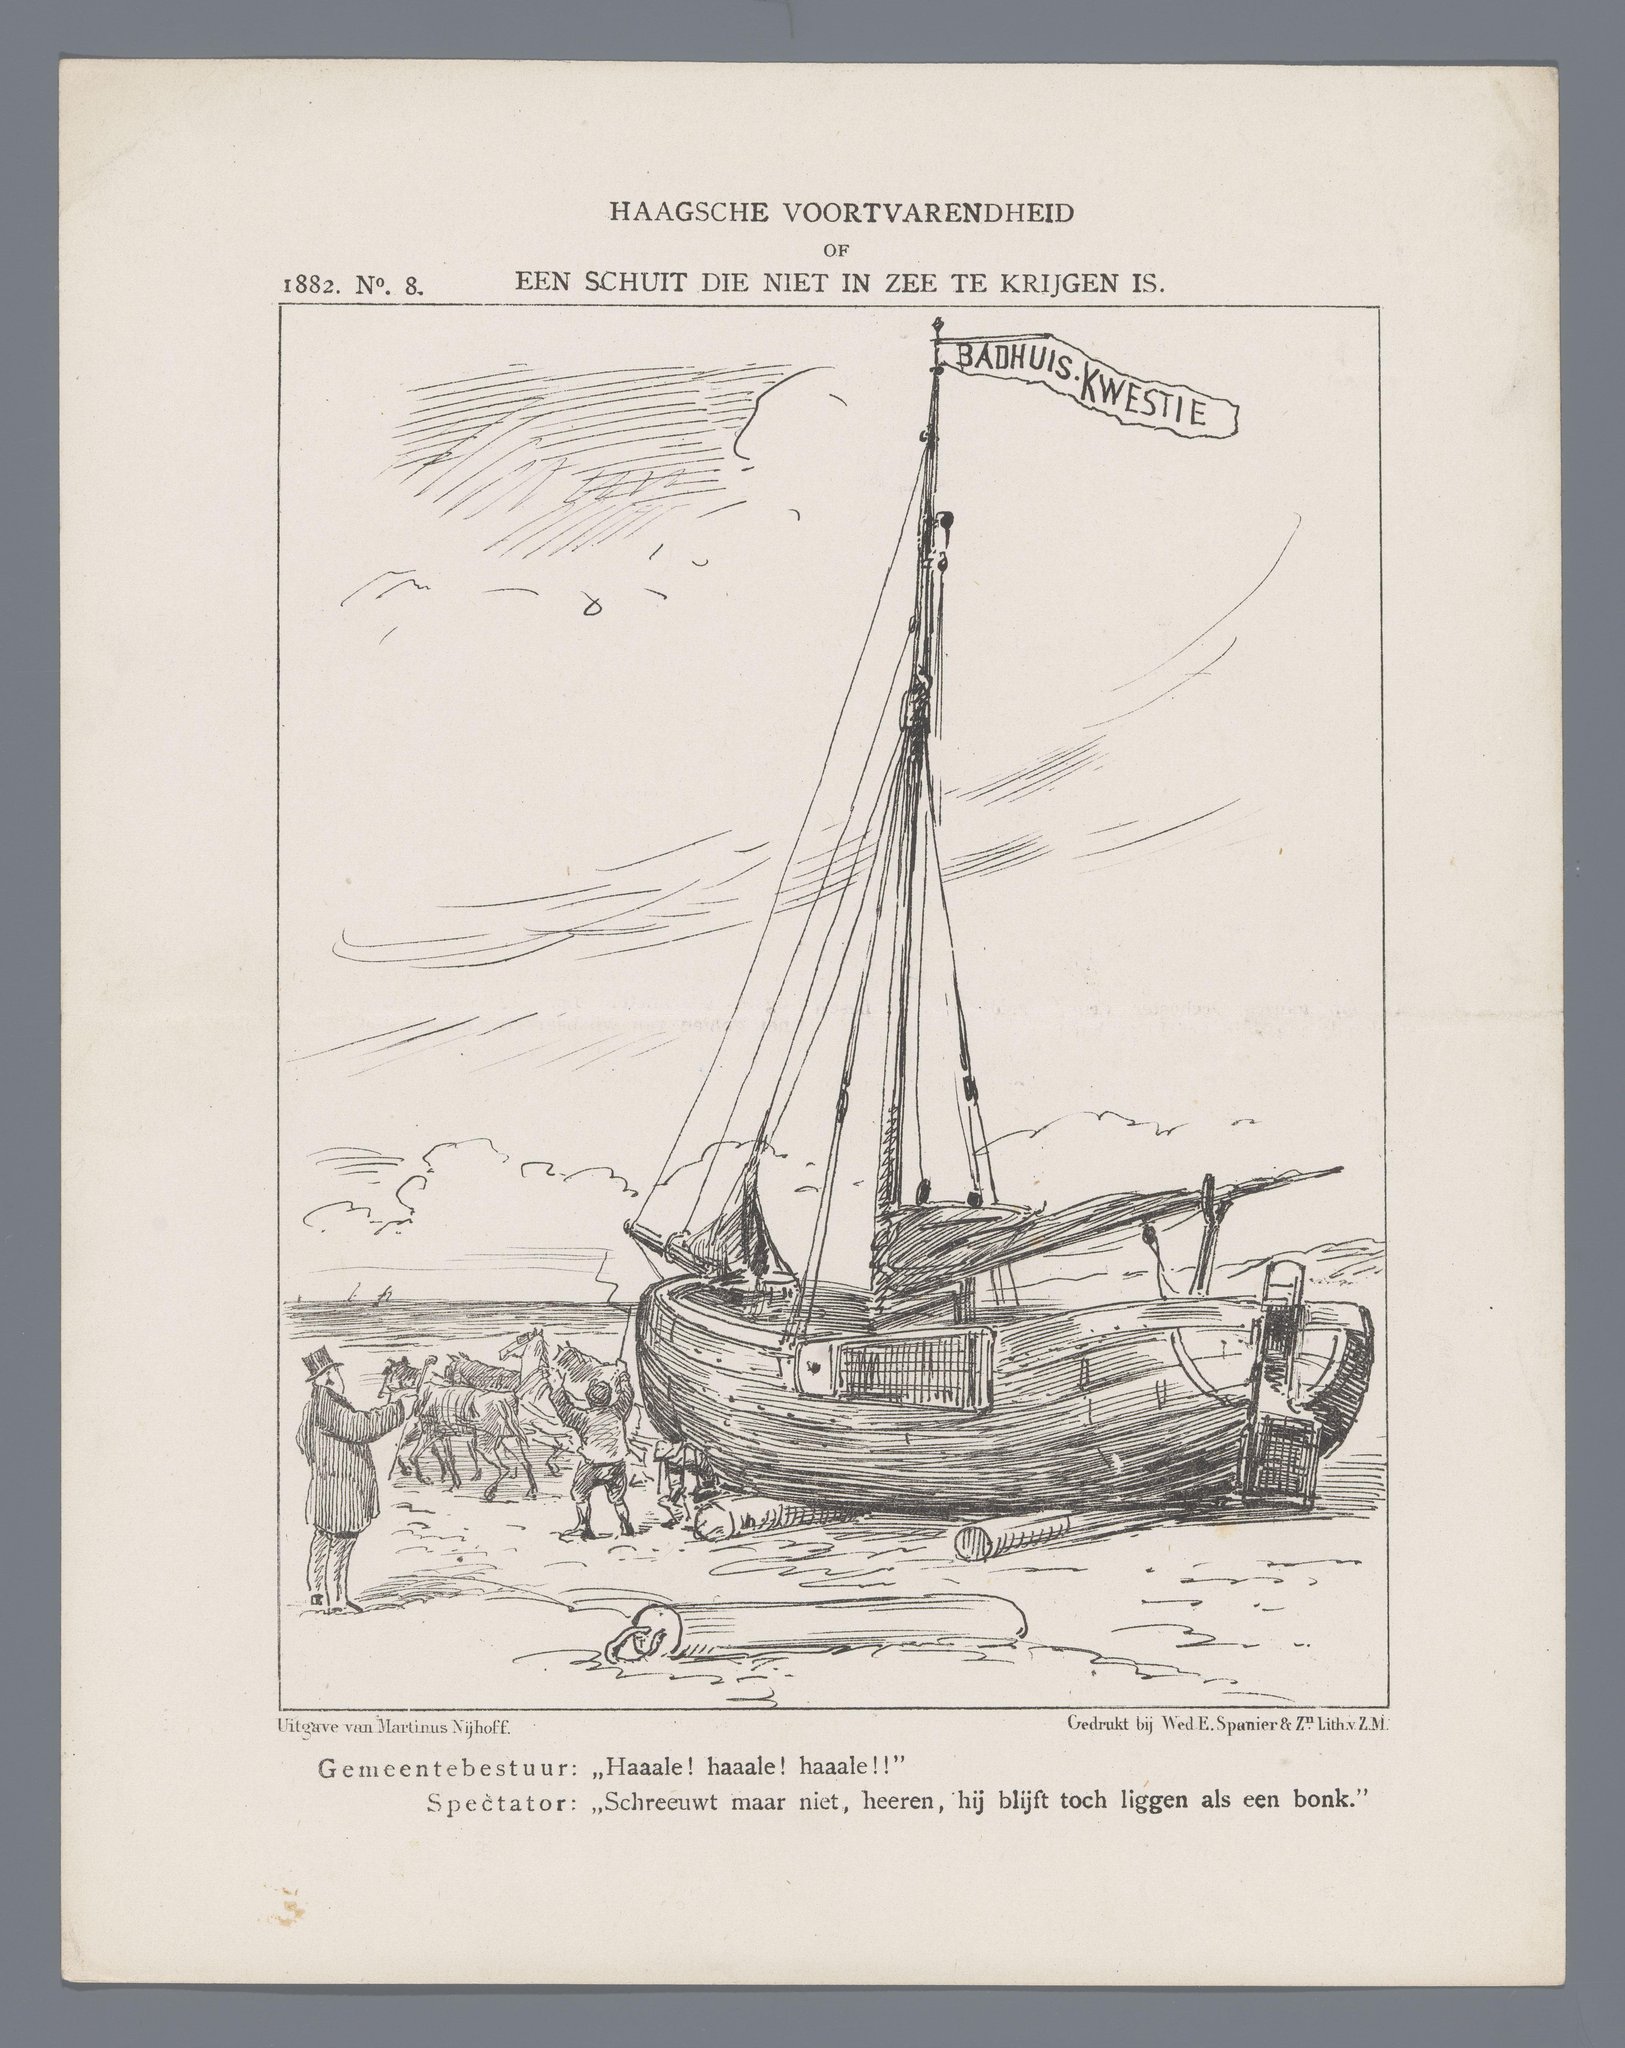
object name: print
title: Politieke spotprent over het gemeentebestuur van Den Haag, 1882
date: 1882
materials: paper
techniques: lithograph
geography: netherlands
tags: the hague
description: Politieke spotprent over het gemeentebestuur van Den Haag: een schip op het strand van Scheveningen. Plaat verschenen bij het weekblad De Nederlandsche Spectator, nr. 8, 1882.